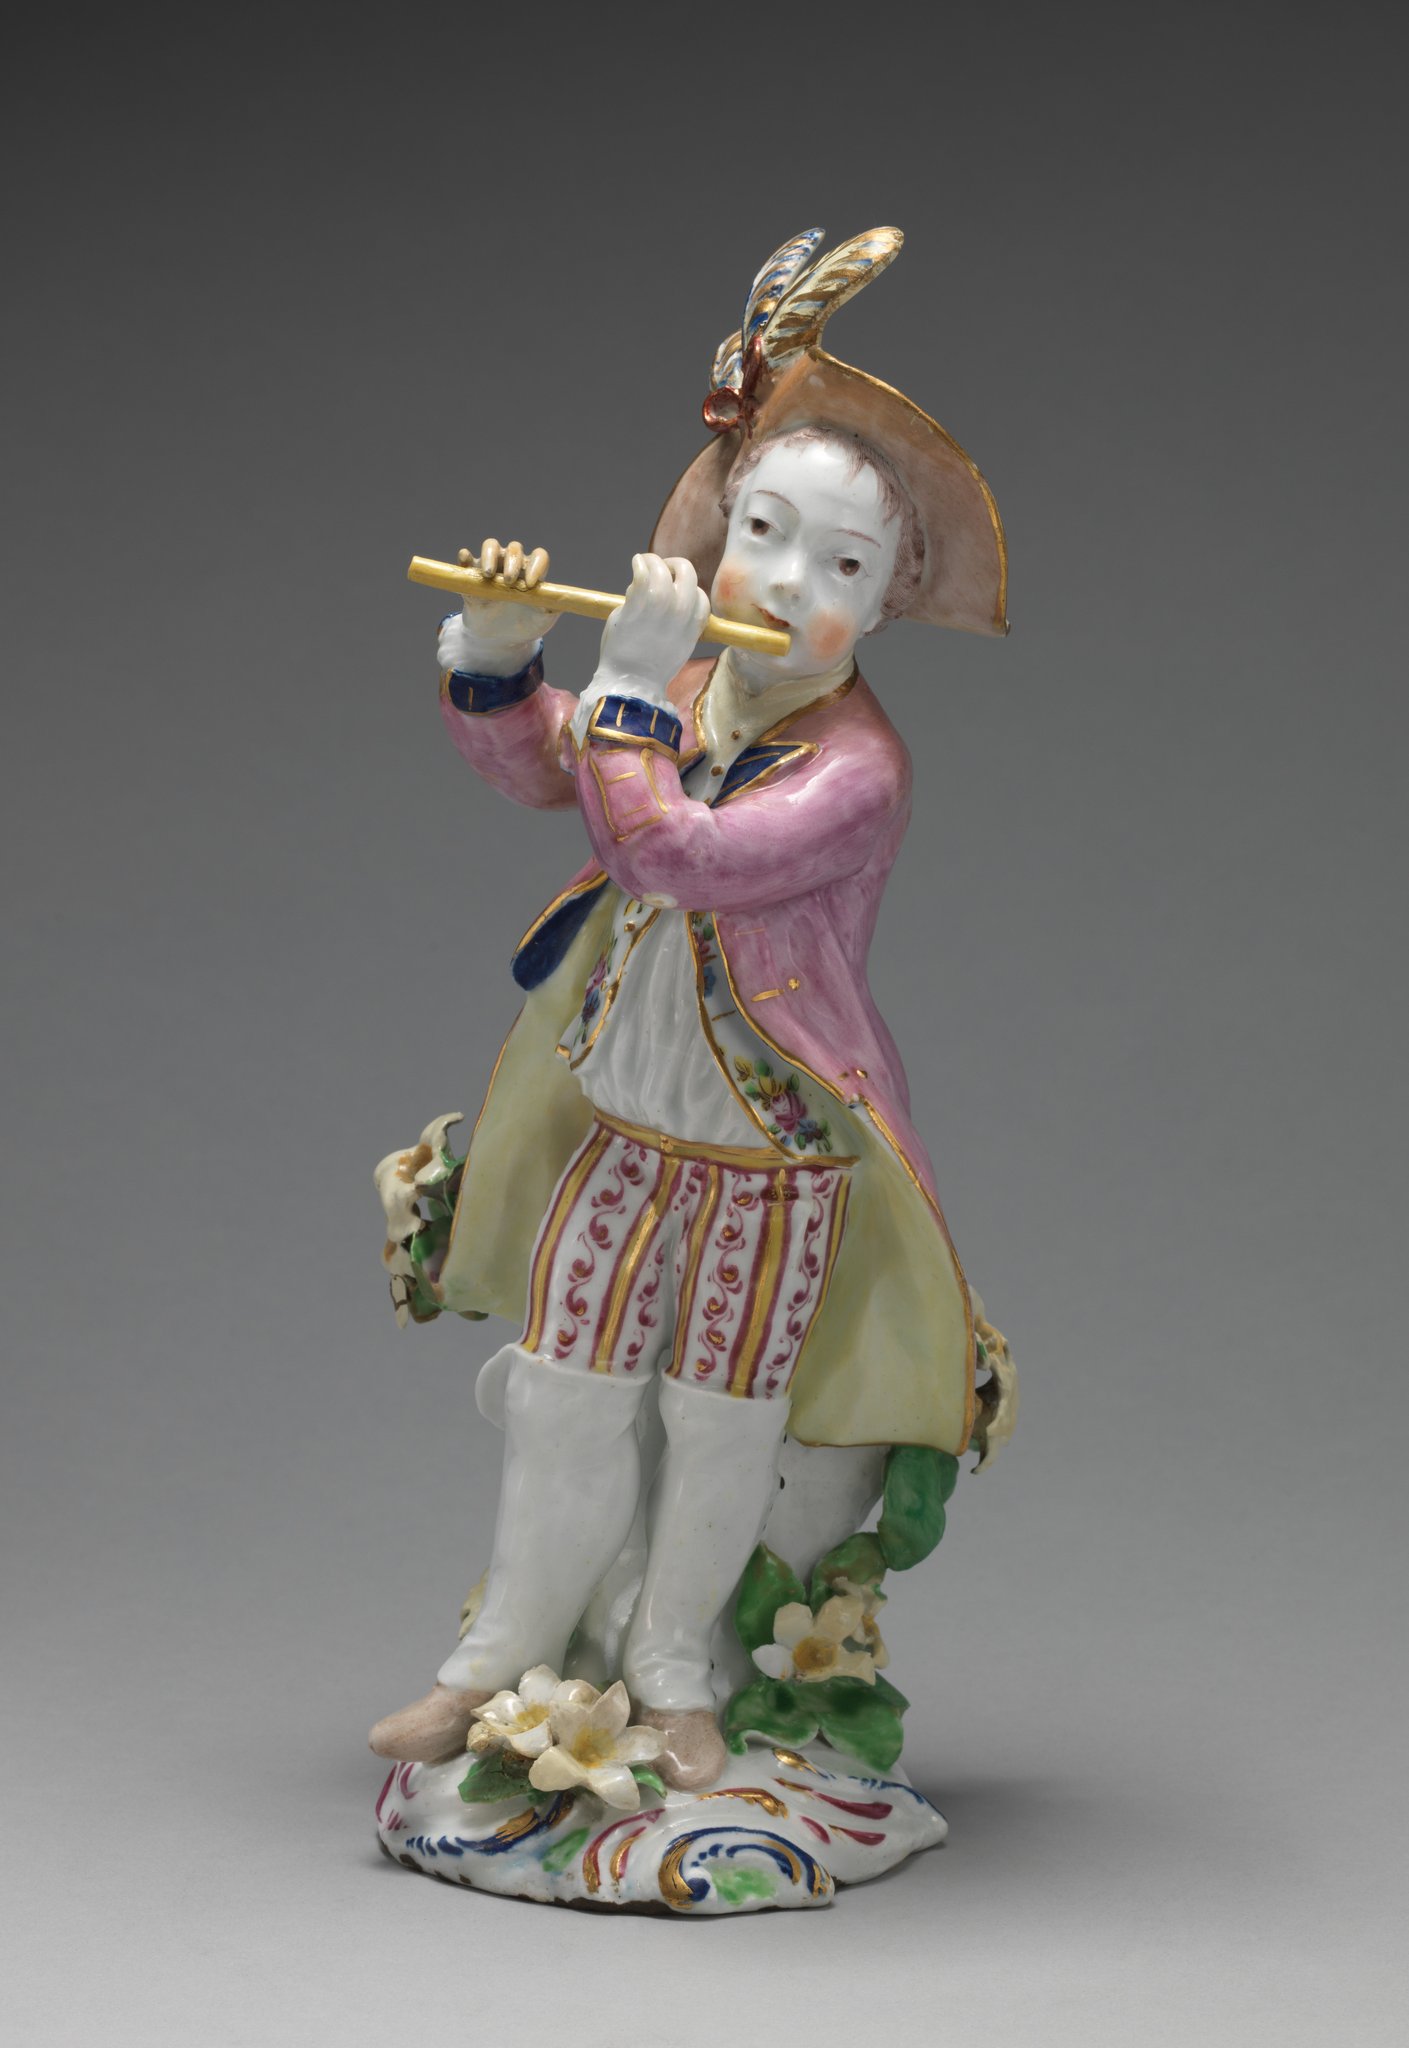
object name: figure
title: Fife player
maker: bow porcelain factory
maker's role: factory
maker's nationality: british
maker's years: 1747-1776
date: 1765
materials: soft paste porcelain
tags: musical instruments,men,musicians